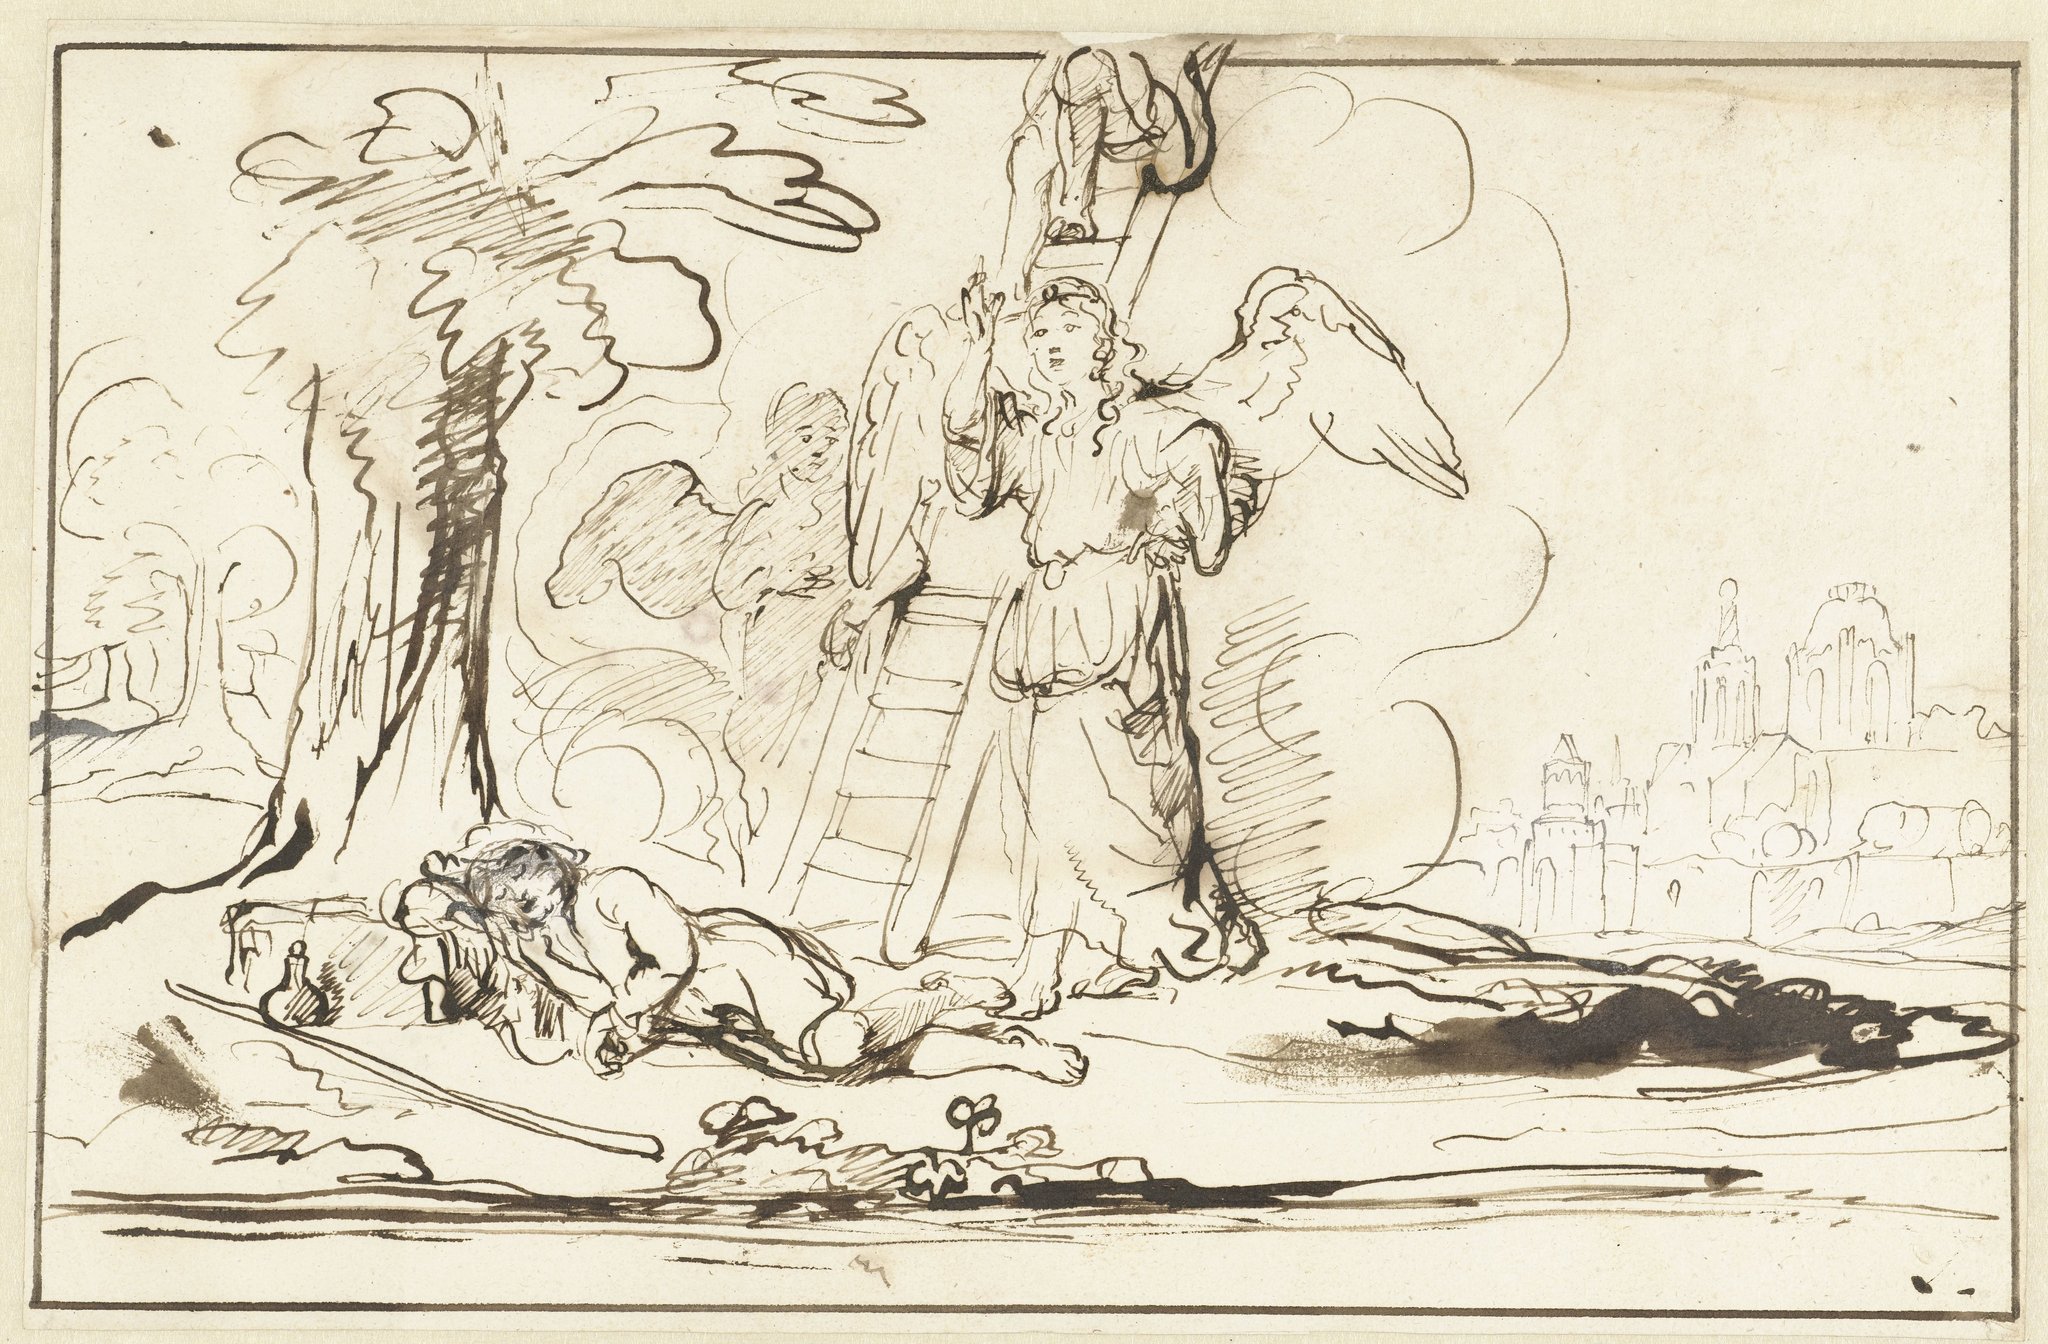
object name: drawing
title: Bijbelse voorstellingen voor album van Matthijs Balen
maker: nicolaes maes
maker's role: draughtsman, painter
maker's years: 1634-1693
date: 1650-1660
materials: paint, ink, paper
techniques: brush, pen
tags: the dream of jacob: while sleeping on the ground with a stone for pillow jacob sees a ladder reaching from earth to heaven with angels going up and down; usually with god at the top of the ladder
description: Afkomstig uit een album met losliggende tekeningen van met name Matthijs Balen.